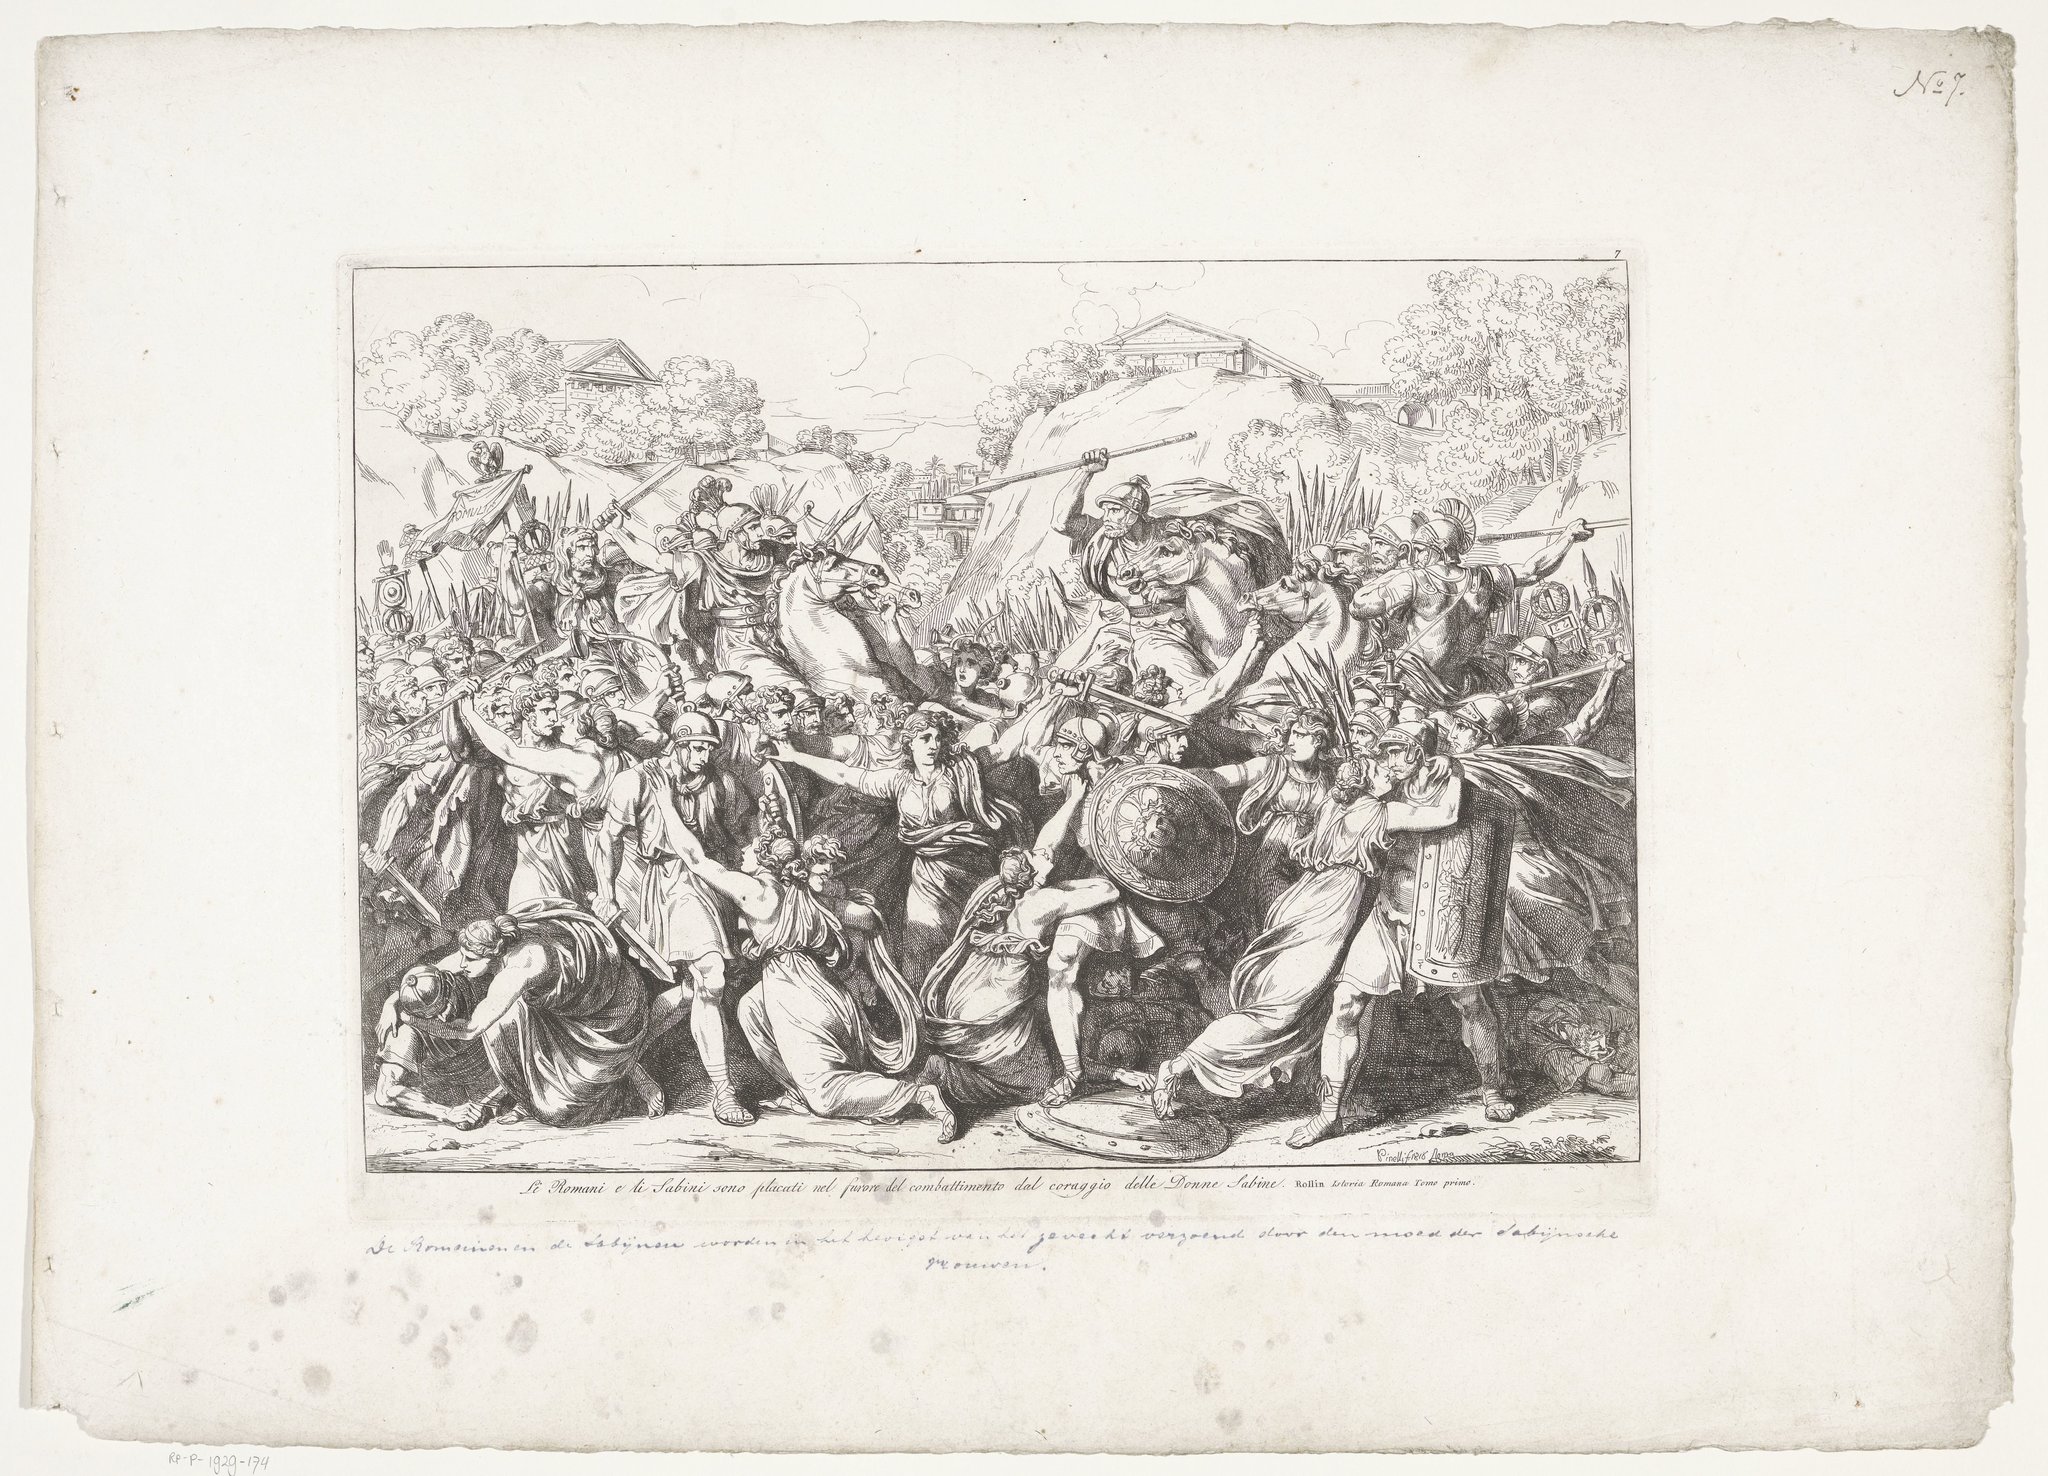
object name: print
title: Frontespizio della Istoria Romana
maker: bartolomeo pinelli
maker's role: draughtsman, print maker, sculptor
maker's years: 1781-1835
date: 1818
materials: paper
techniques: etching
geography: rome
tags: reconciliation of the sabines and the romans: the women, some holding their babies, others with their hair loose, and possibly encouraged by hersilia call for peace in the midst of the two fighting armies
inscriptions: inscription: ‘De Romeinen en de Sabijnen worden in het hevig[...] van het gevecht verzoend door den moed der Sabijnsche / vrouwen.’, collector's mark: Lugt 2228, number: ‘No 7’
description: De Sabijnse maagden werpen zich tussen de twee vechtende legers van Sabijnen en Romeinen. Ze doen een oproep tot vrede.